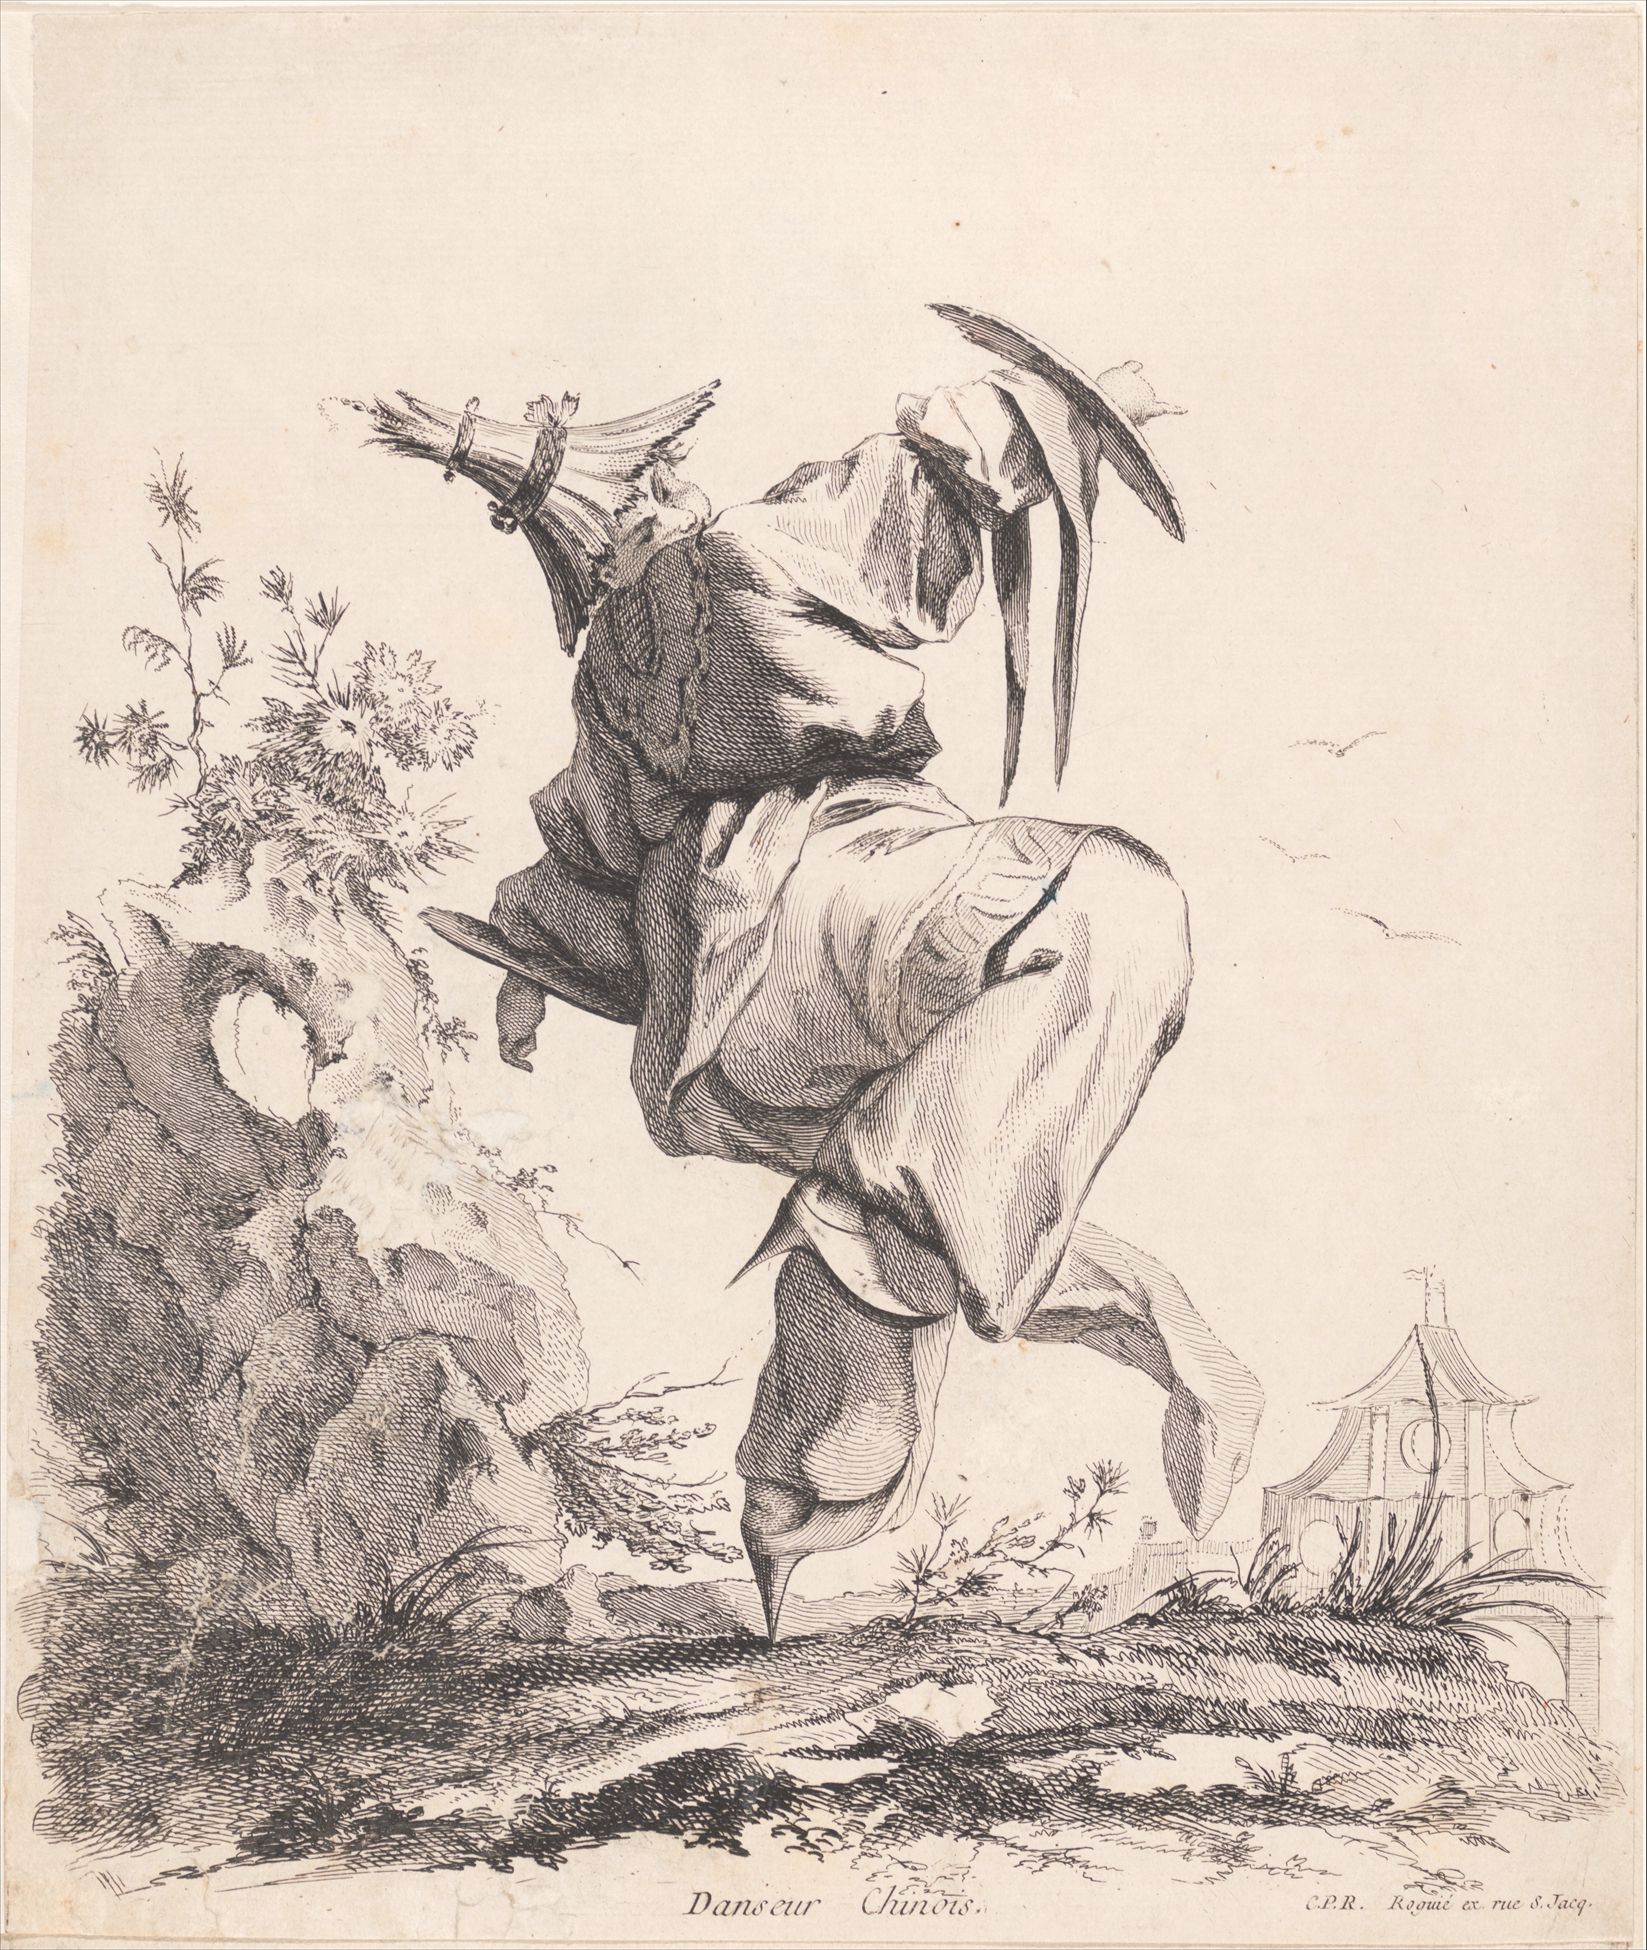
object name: collection ornament architecture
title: Livre de Chinois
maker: françois boucher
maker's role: artist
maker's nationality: french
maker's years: 1703-1770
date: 1720-1770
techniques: engraving, etching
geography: france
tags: tents,men